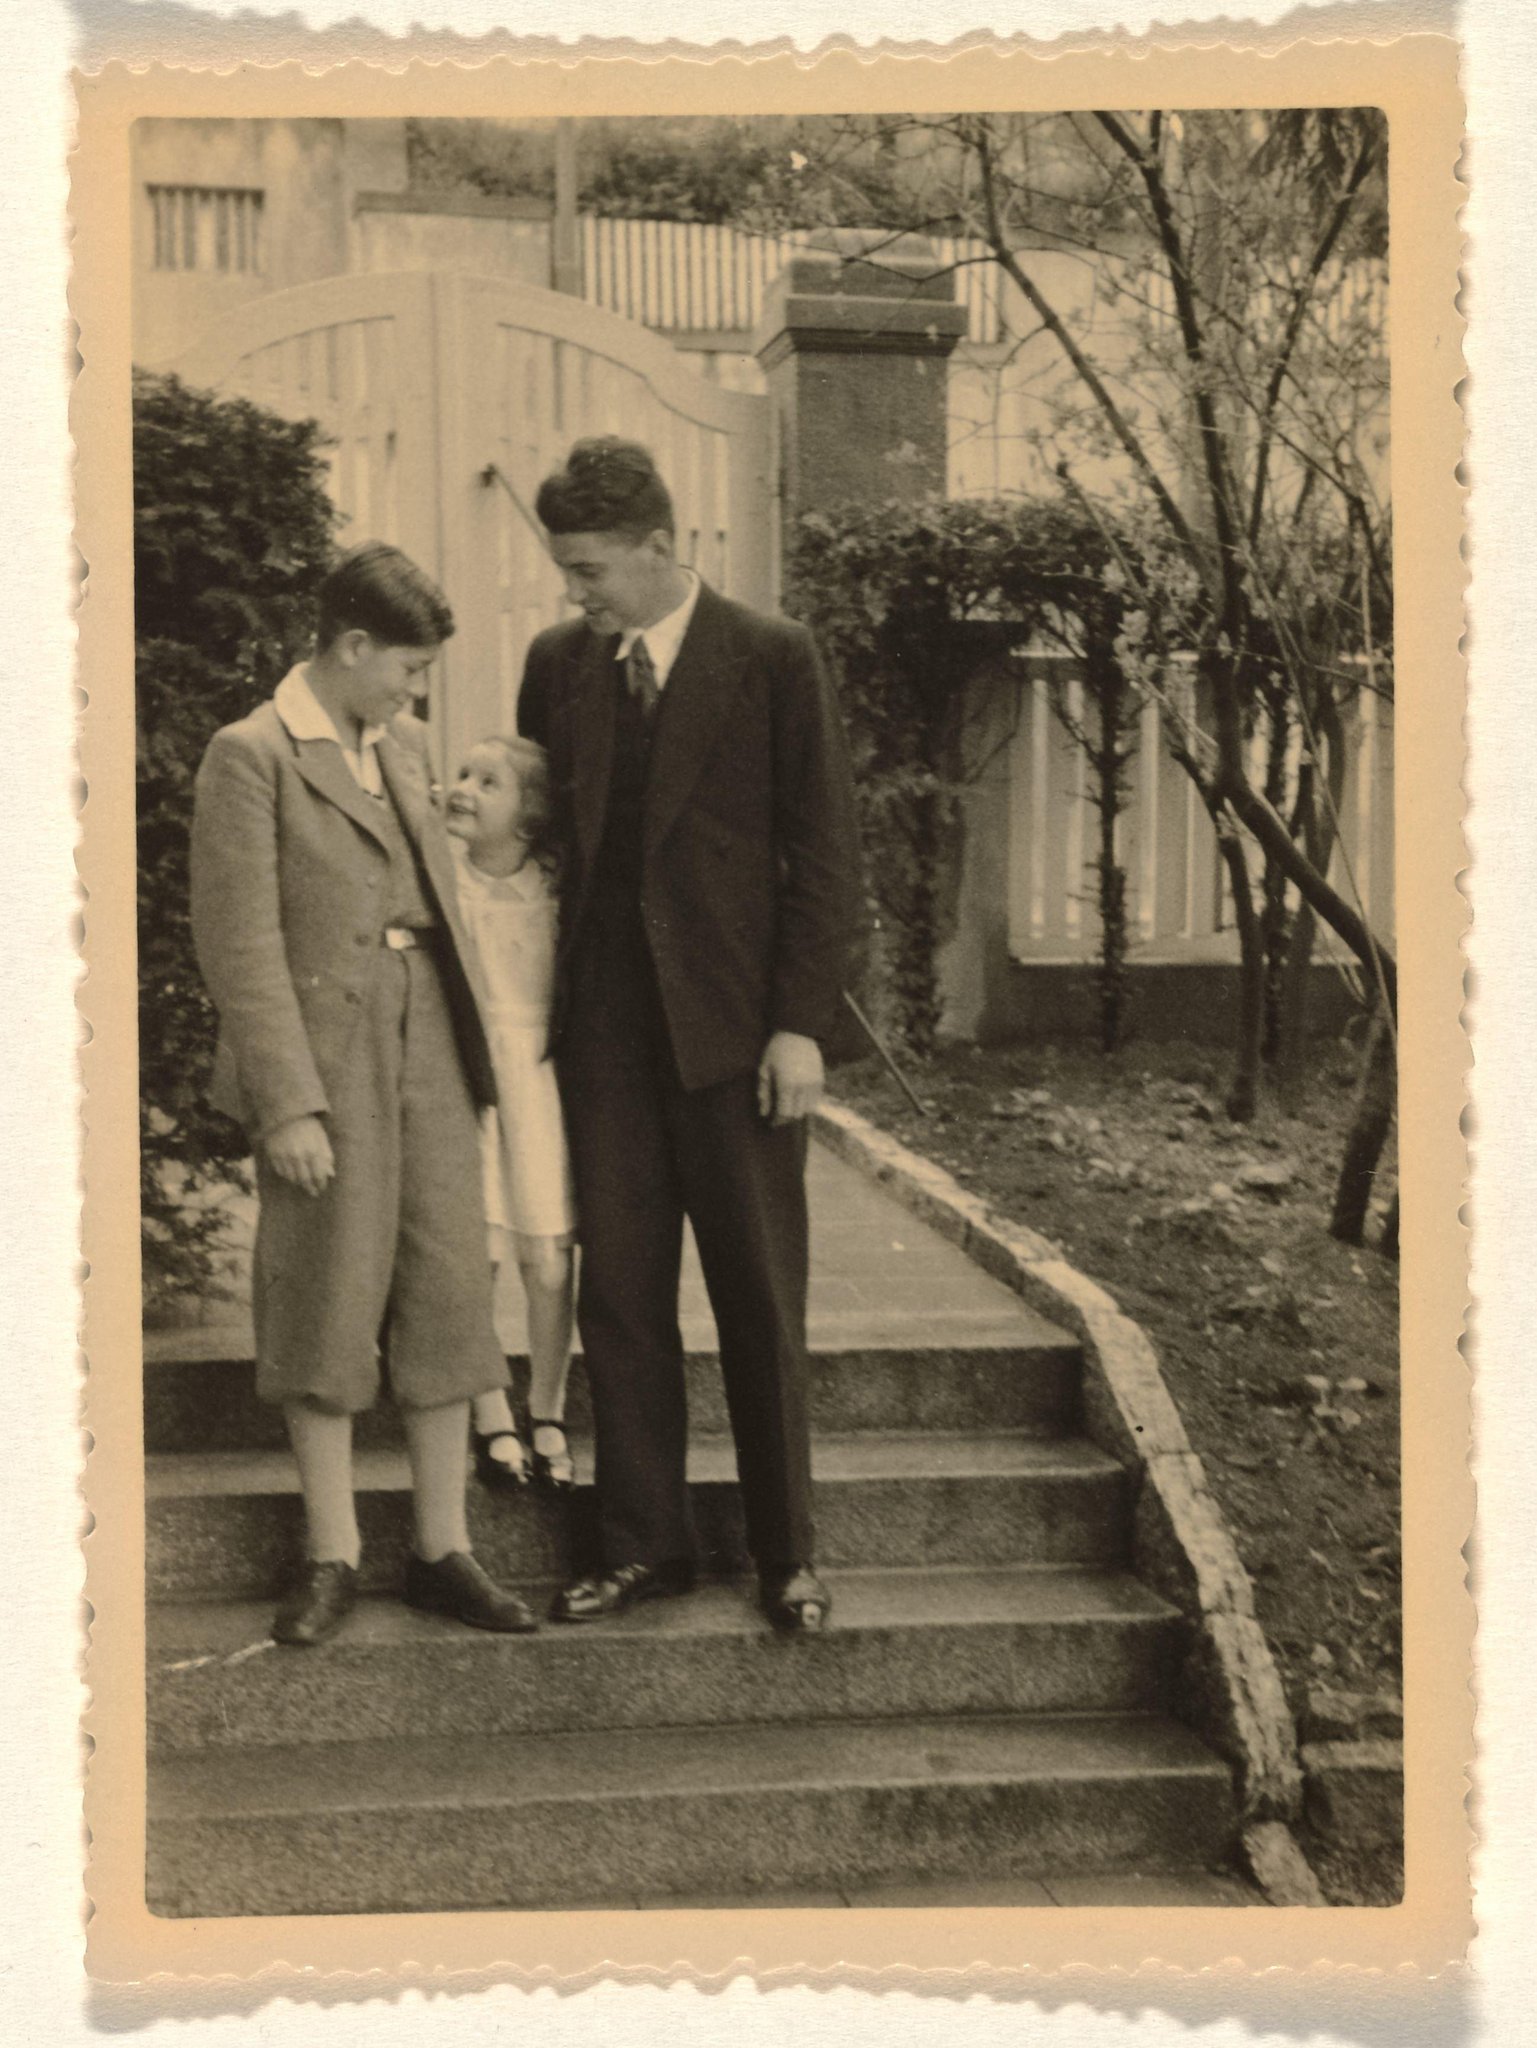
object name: photograph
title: Isabel Wachenheimer met haar neven Klaus en Werner Zürndorfer, in de tuin van de familie Wachenheimer in Stuttgart, 1935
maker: Anonymous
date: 1935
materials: photographic support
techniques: gelatin silver print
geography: stuttgart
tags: isabel wachenheimer-elon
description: Dit object is onderdeel van de nalatenschap van Isabel Elon-Wachenheimer (1928-2010). Tot haar overlijden behoorde het samen met de andere objecten uit de nalatenschap tot haar privédomein van Isabel Wachenheimer. In die particuliere context zijn deze objecten tezamen en individueel aandenkens - aan de jeugd, ouders en familie van Isabel Wachenheimer vóór en tijdens de Shoah en aan haar leven na de Tweede Wereldoorlog. Isabel Wachenheimer, die van juni 1943 tot mei 1945 gevangen zat in Kamp Westerbork, Theresienstadt, Auschwitz, Lenzing a/d Oberdonau (een buitenkamp van Mauthausen), overleefde de Shoah. Haar ouders – Eugène Wachenheimer en Else Wachenheimer-Moos - werden op 14 oktober 1944 in Auschwitz-Birkenau vermoord.